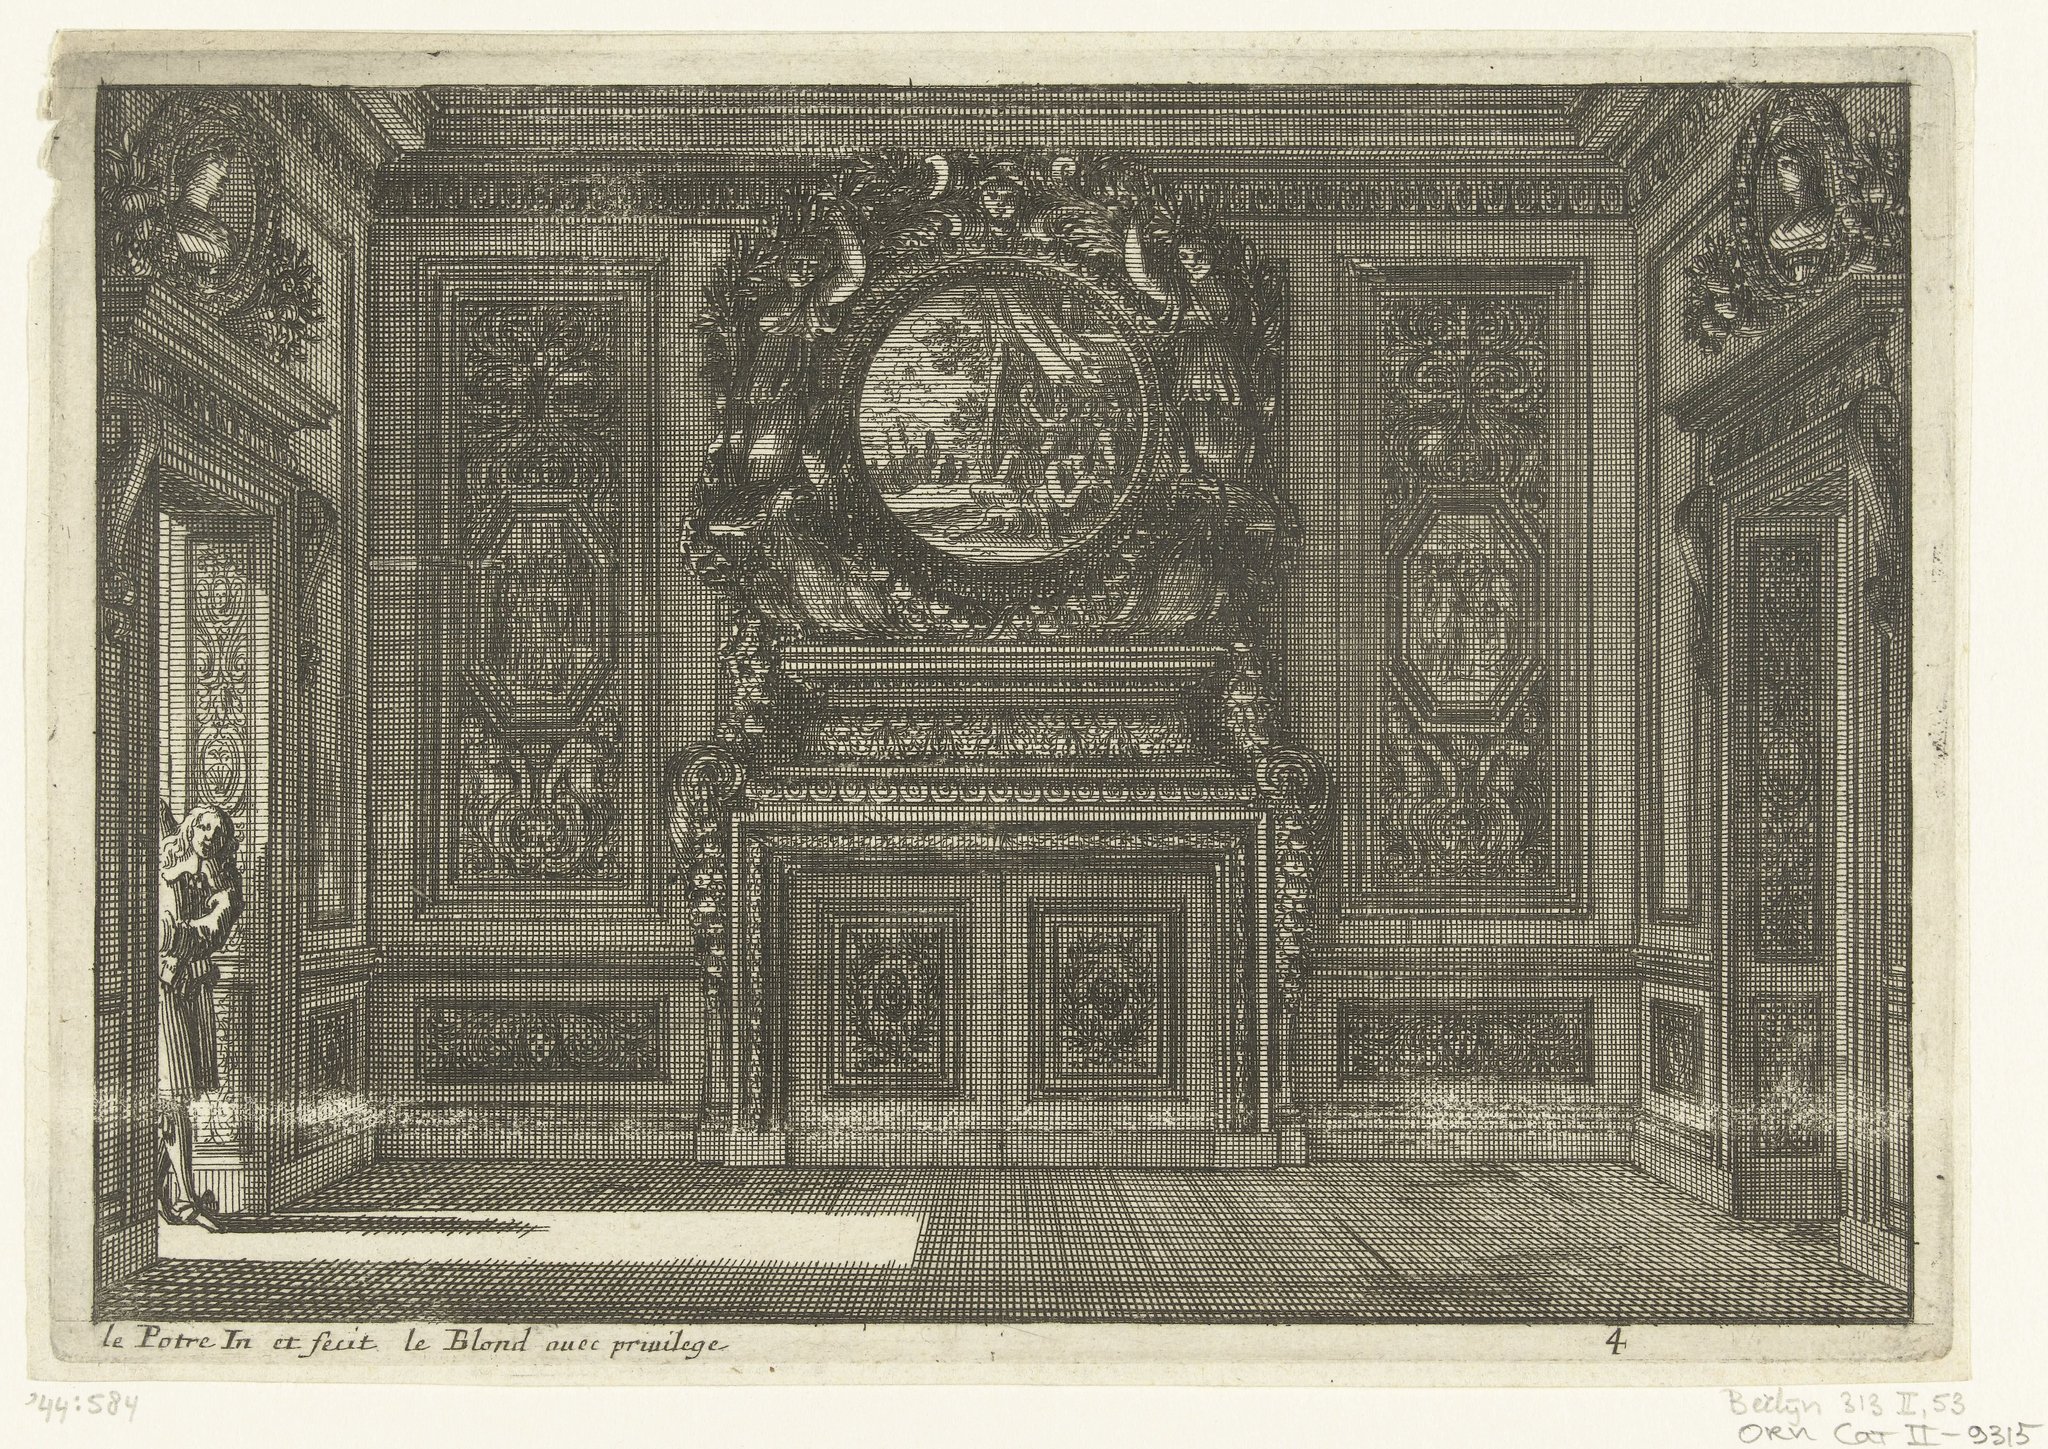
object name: print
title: Kamer met schouw met luiken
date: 1650-1664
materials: paper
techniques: etching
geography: paris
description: Kamer met schouw in het midden. De schoorsteenmantel is afgesloten met twee leuken. Daarboven een rond medaillon met een Bacchische scène. Links opent een bediende een deur.